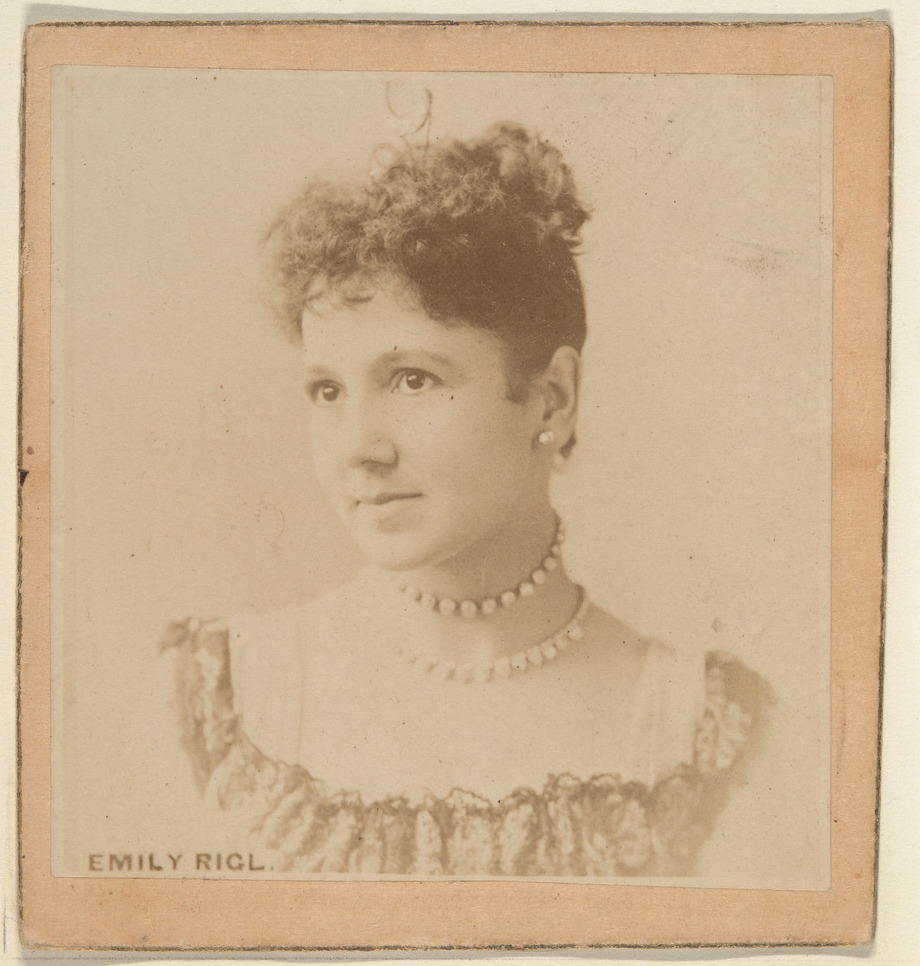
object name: photograph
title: Emily Rigl, from the Actresses series (N246), Type 2, issued by Kinney Brothers to promote Sporting Extra Cigarettes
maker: kinney brothers tobacco company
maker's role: publisher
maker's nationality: american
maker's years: 1869-2011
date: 1890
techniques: albumen silver print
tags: portraits,women,actresses